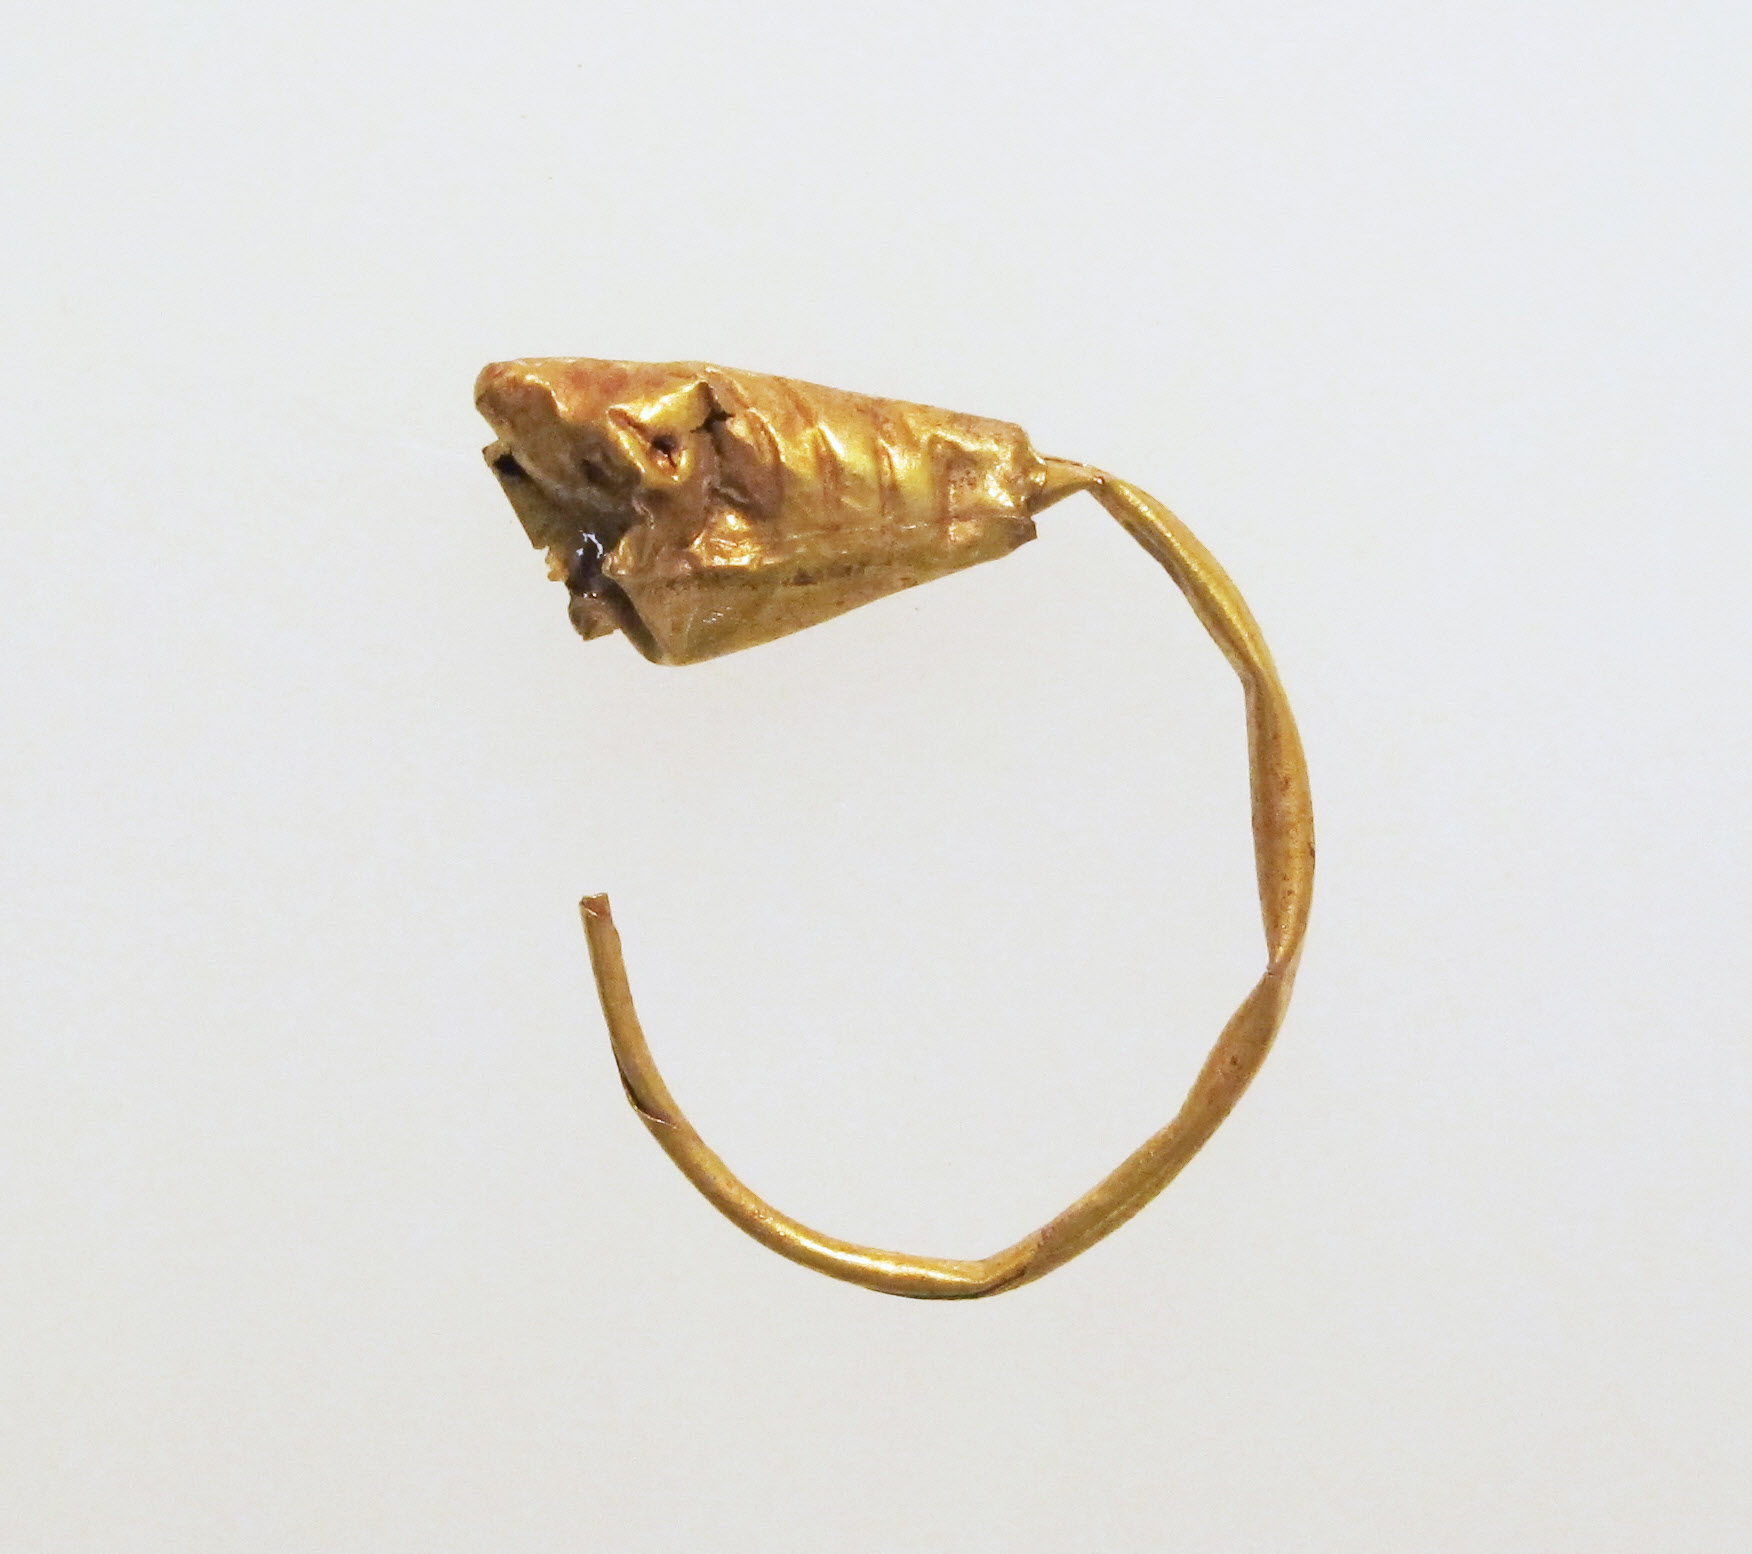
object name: earring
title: Gold earring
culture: greek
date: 400-201 BCE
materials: gold